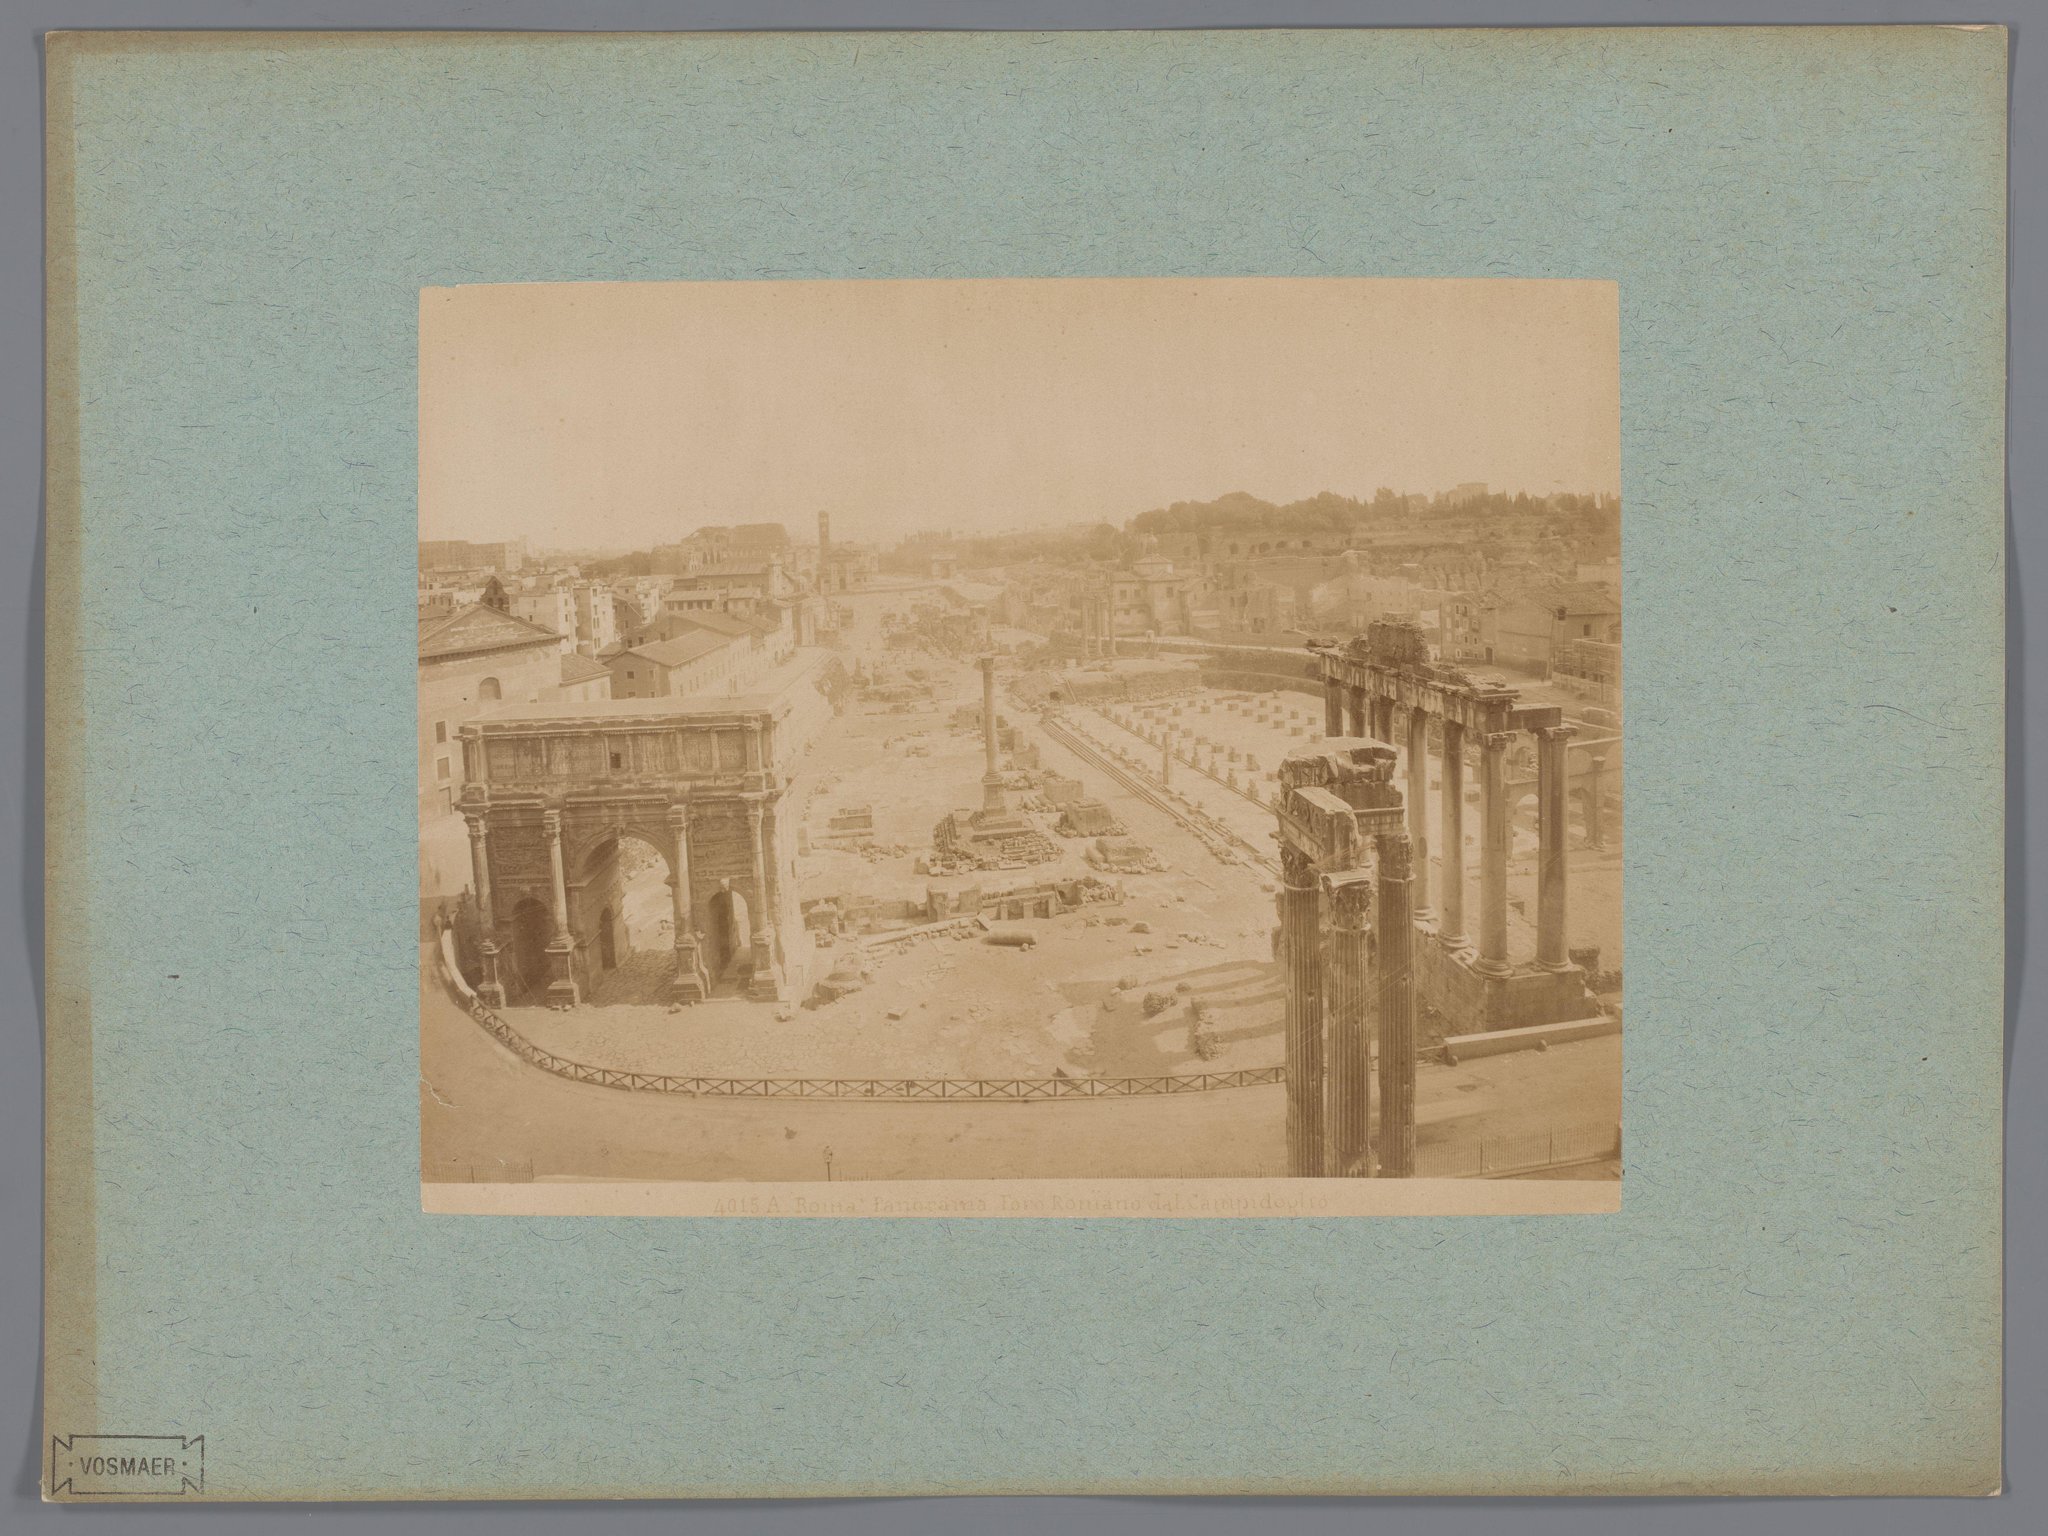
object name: photograph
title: Roma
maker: Anonymous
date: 1851-1900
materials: cardboard, paper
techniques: albumen print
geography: rome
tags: landscape with ruins, rome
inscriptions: number: ‘4015A.’, collector's mark: ‘VOSMAER’